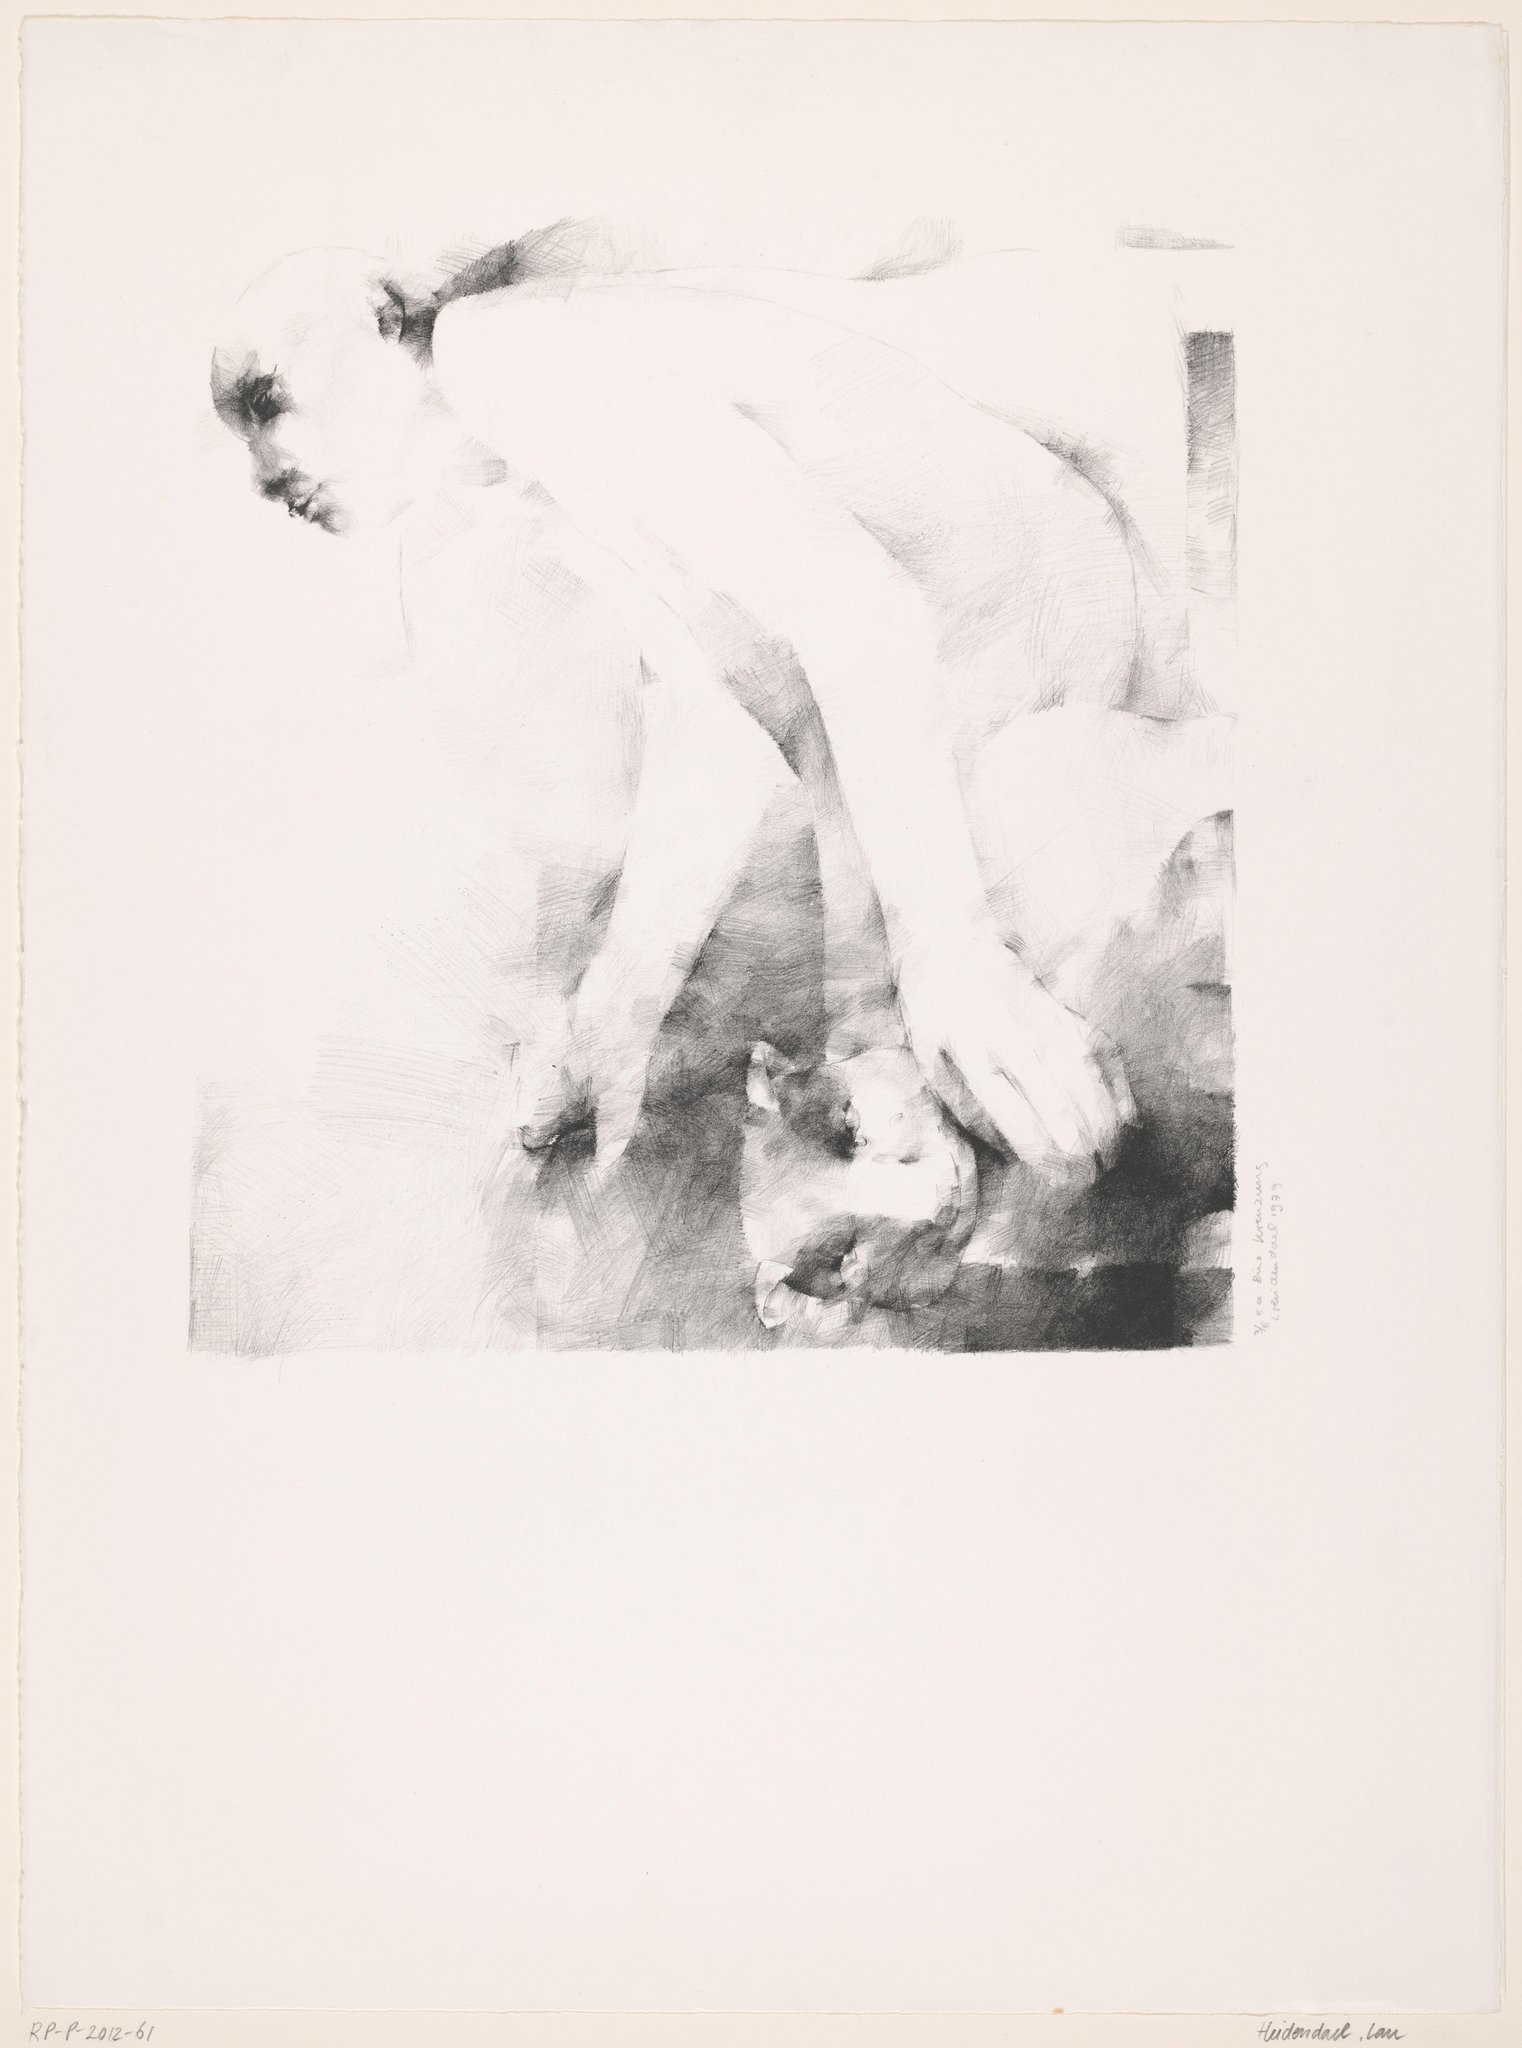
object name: print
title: Eine Kreuzung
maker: lau heidendael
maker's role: print maker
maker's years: 1946-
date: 1979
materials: paper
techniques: lithograph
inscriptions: edition: ‘3/8 e.a.’, title: ‘Eine Kreuzung’, signature and date: ‘LHeidendael 1979’